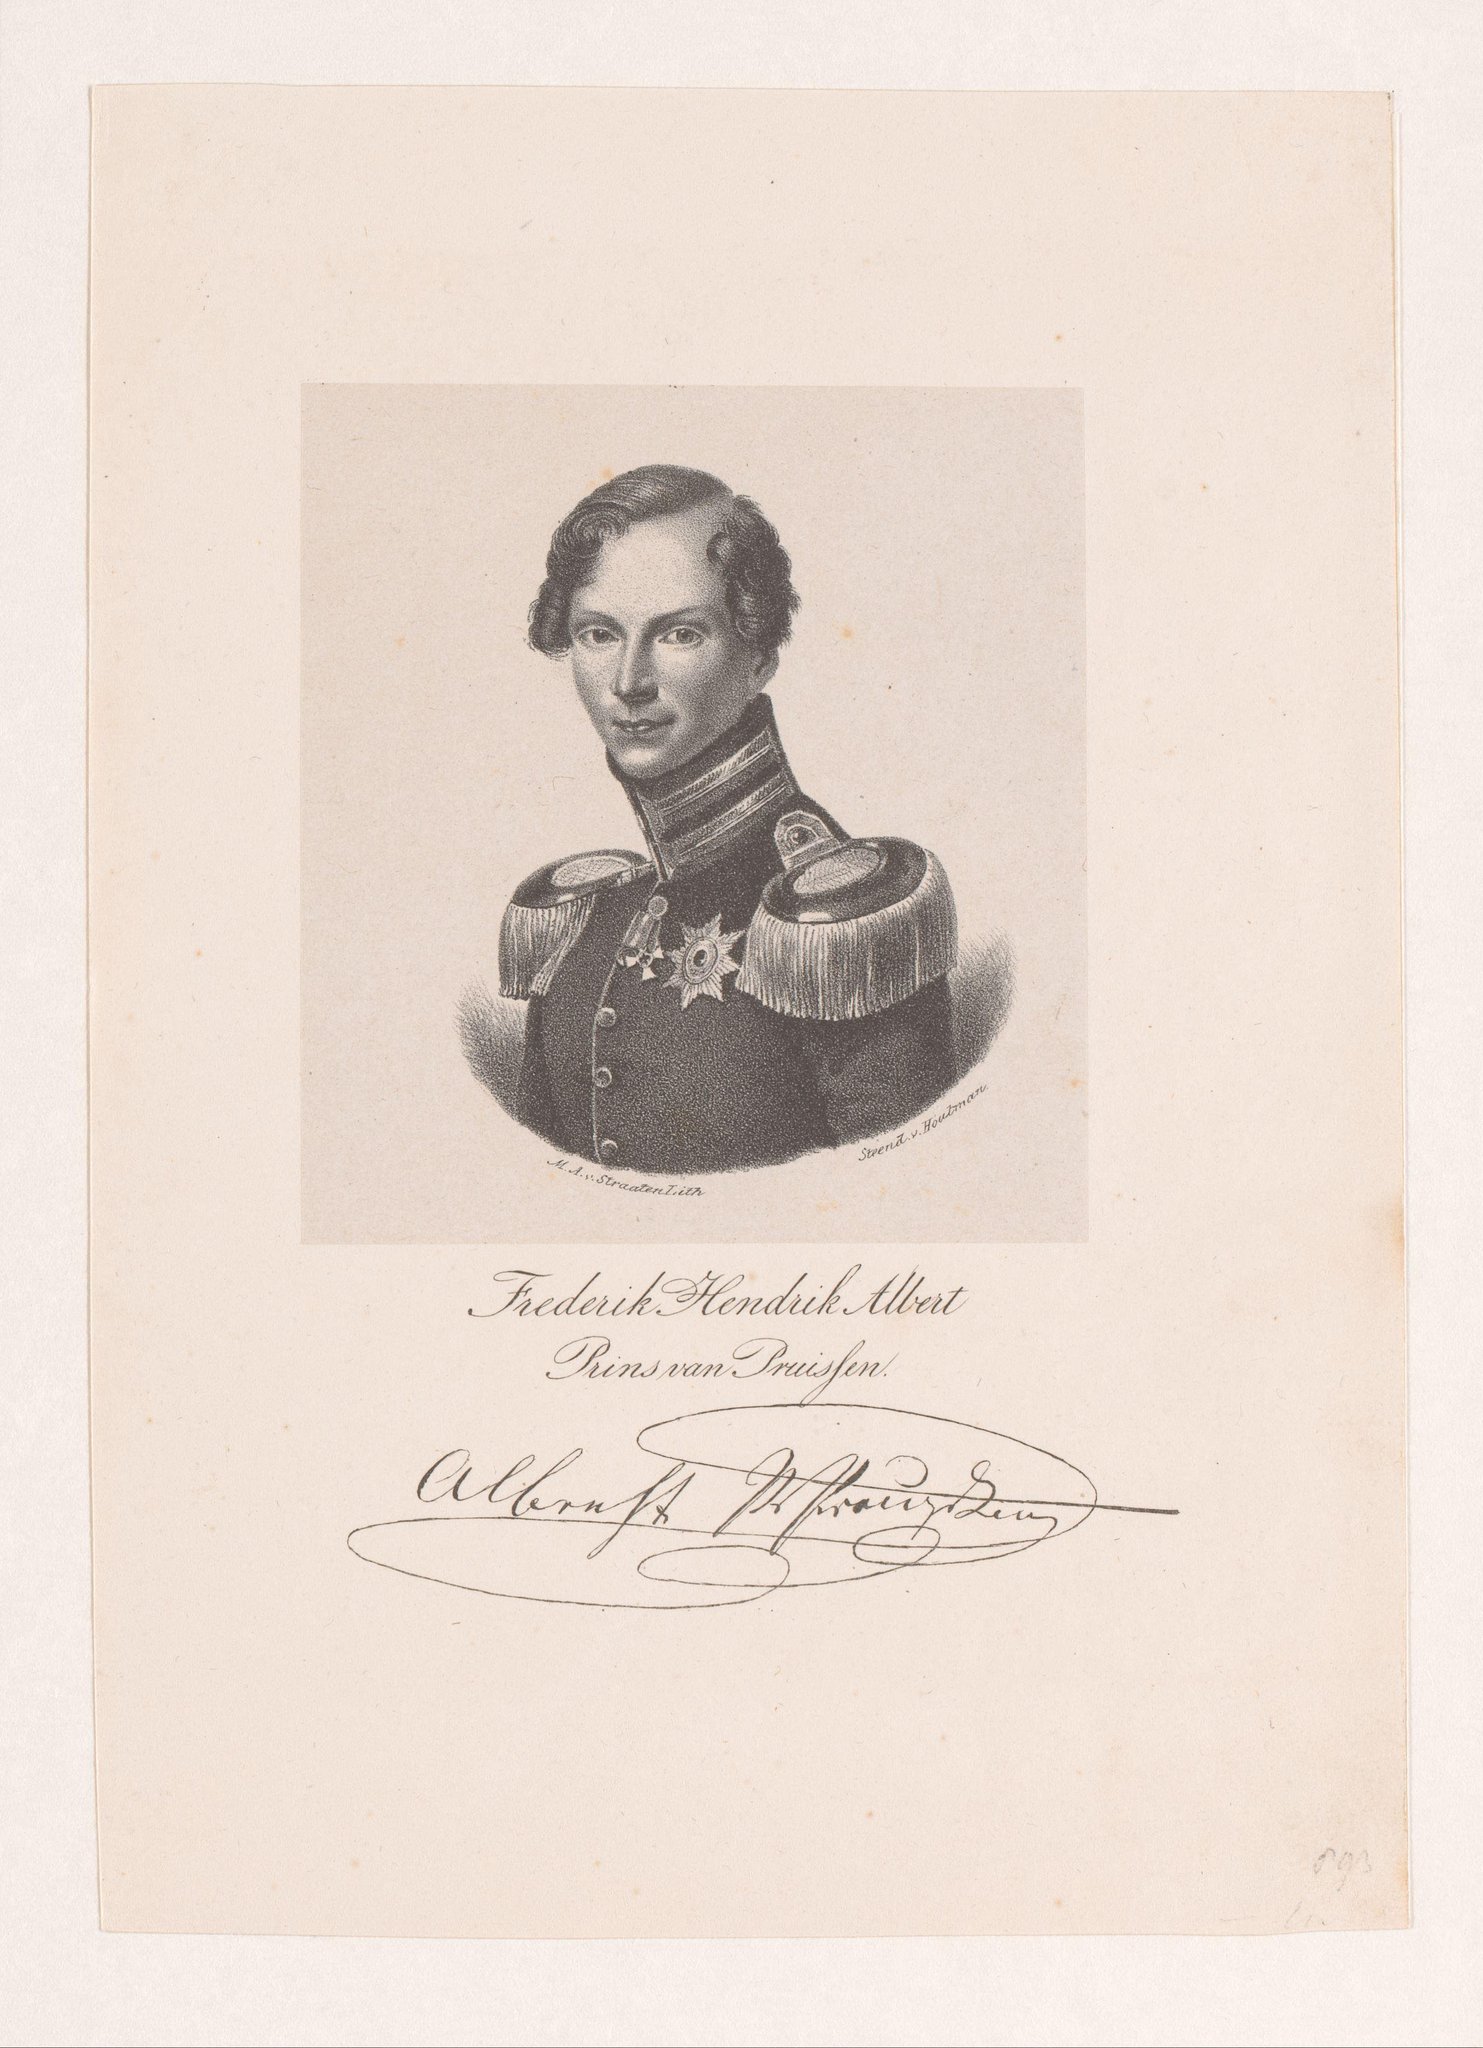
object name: print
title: Portret van Albrecht Friedrich Heinrich van Pruisen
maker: marinus adrianus van straten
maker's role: print maker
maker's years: 1808-1863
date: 1828-1843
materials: paper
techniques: lithograph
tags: berlin, historical persons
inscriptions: stamp: ‘F’, collector's mark: Lugt 2228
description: Onder het portret de signatuur van de geportretteerde.